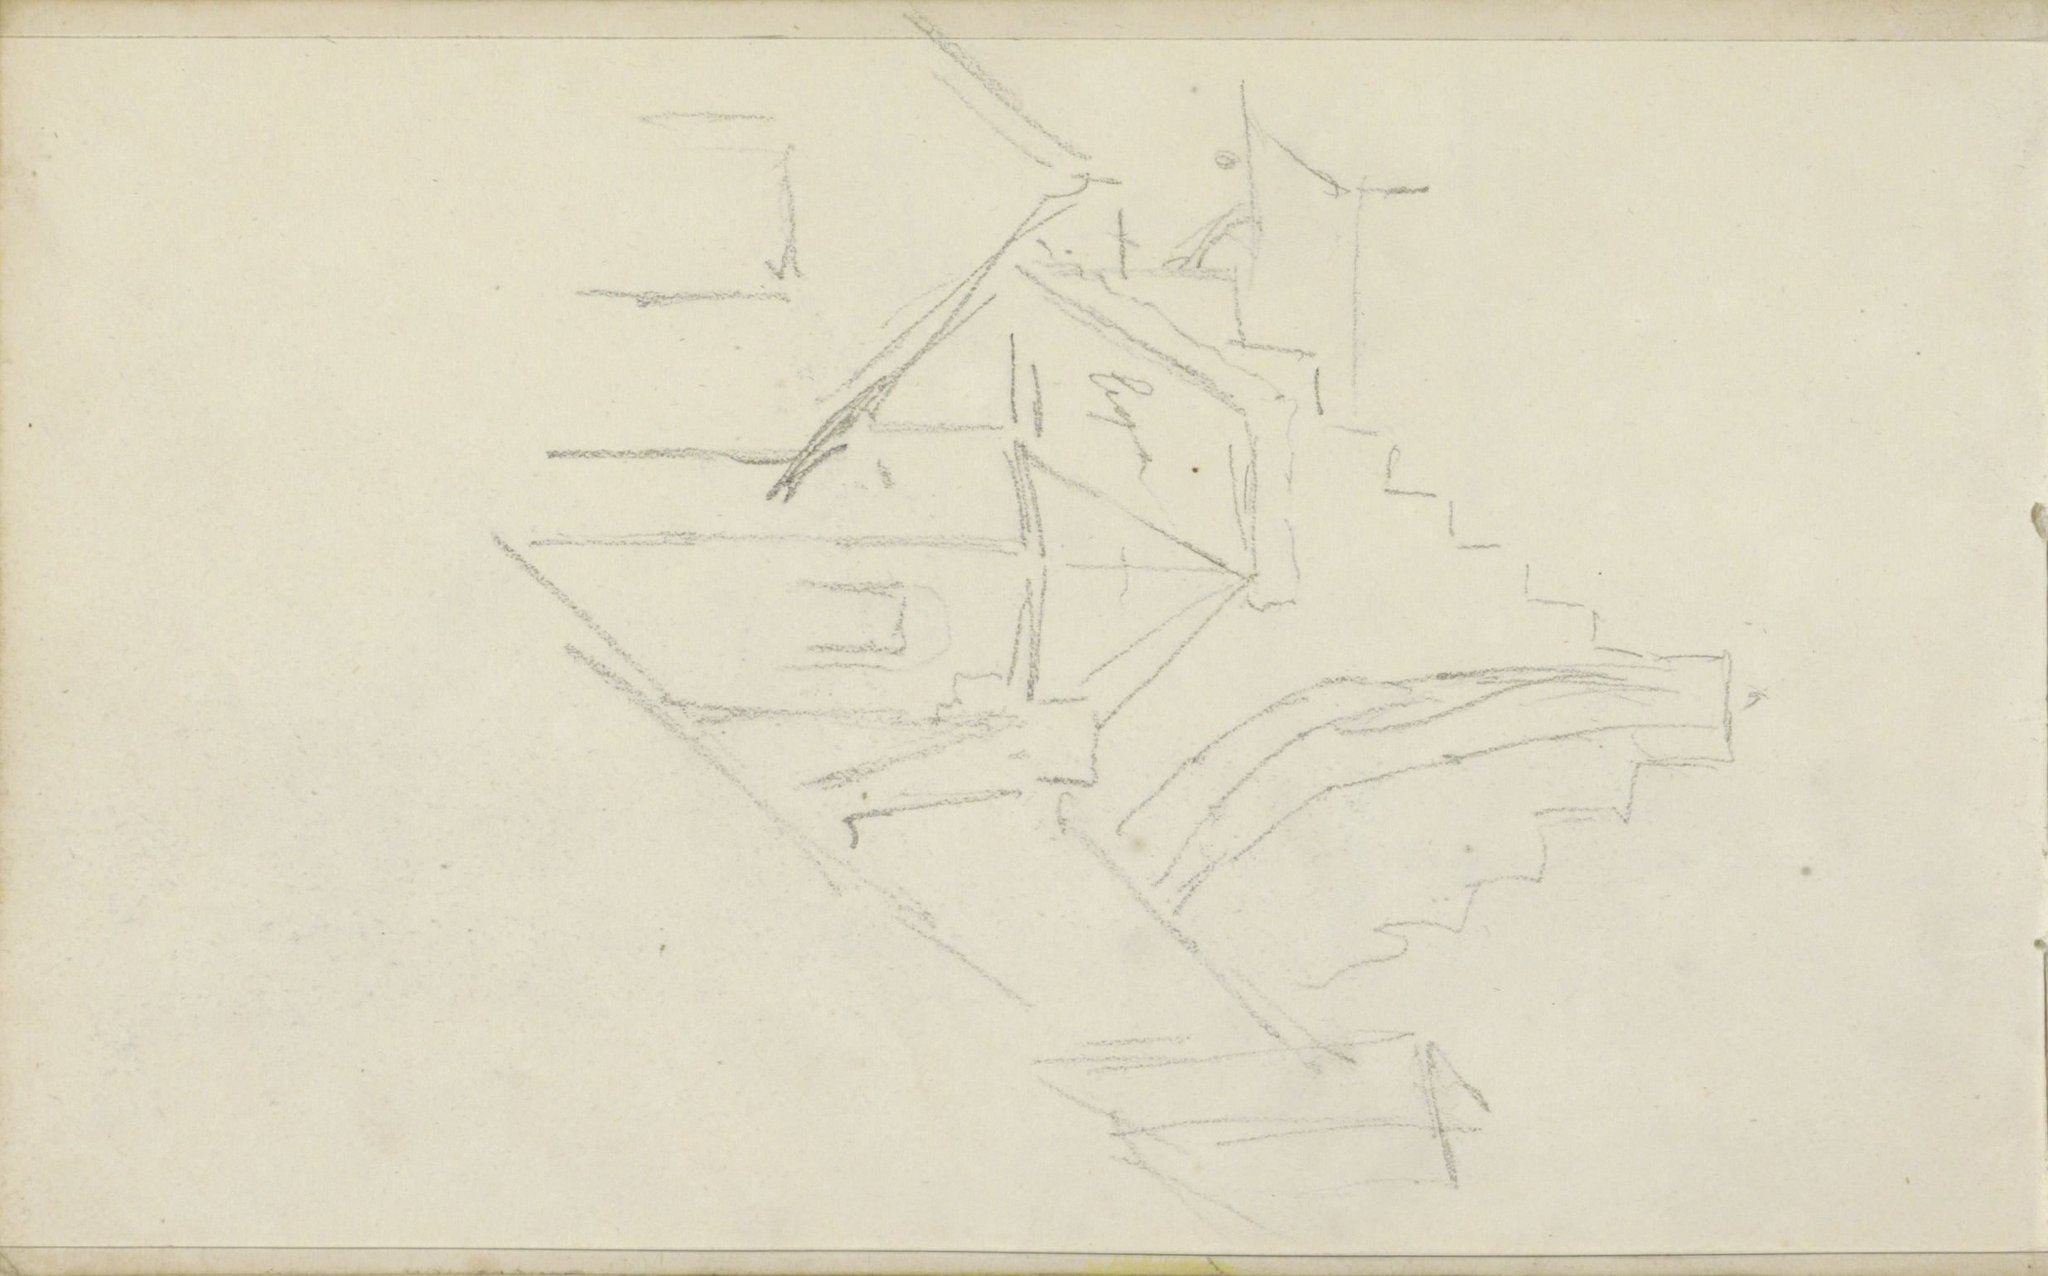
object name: sketchbook leaf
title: Gezicht op gebouwen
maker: adrianus eversen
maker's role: draughtsman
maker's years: 1818-1897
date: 1828-1897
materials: paper, pencil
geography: netherlands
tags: urban housing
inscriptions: kleurnotitie, handgeschreven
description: Gezicht op gebouwen, waaronder een gebouw met een trapgevel. Blad 12 verso uit een schetsboek met 27 bladen.